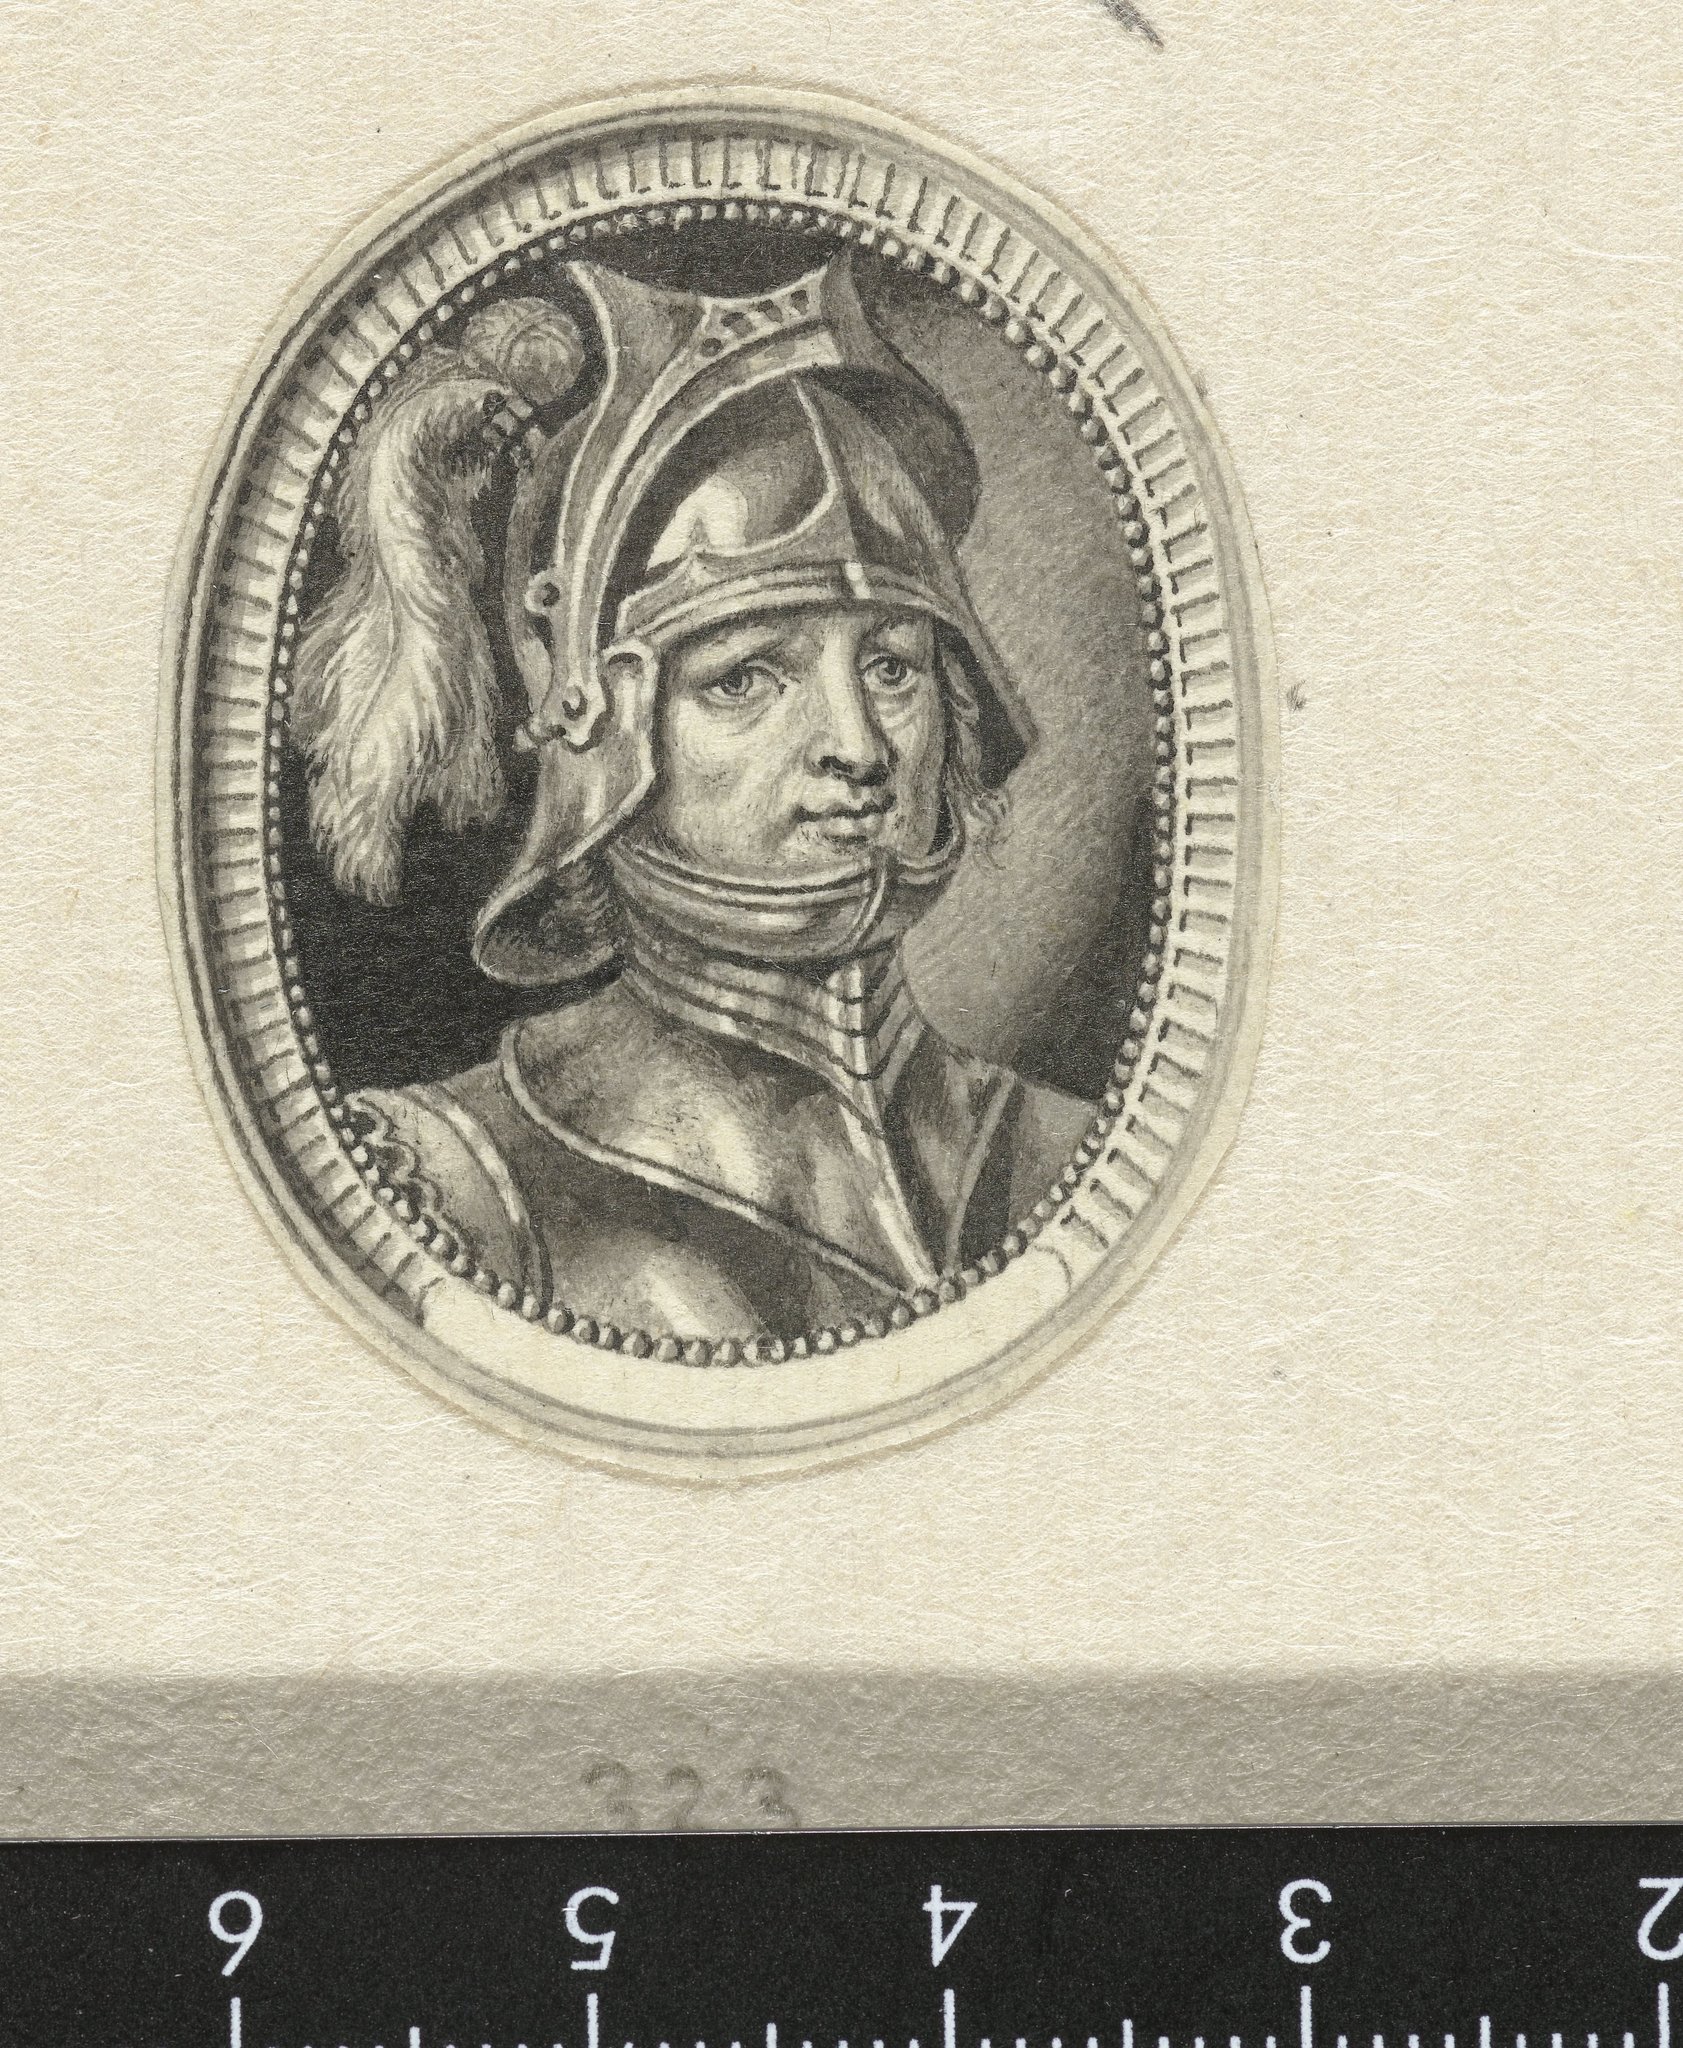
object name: design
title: Ovaal portret van een ridder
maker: jacques kuyper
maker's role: draughtsman, print maker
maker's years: 1761-1808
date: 1771-1808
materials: ink, paper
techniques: brush, pen